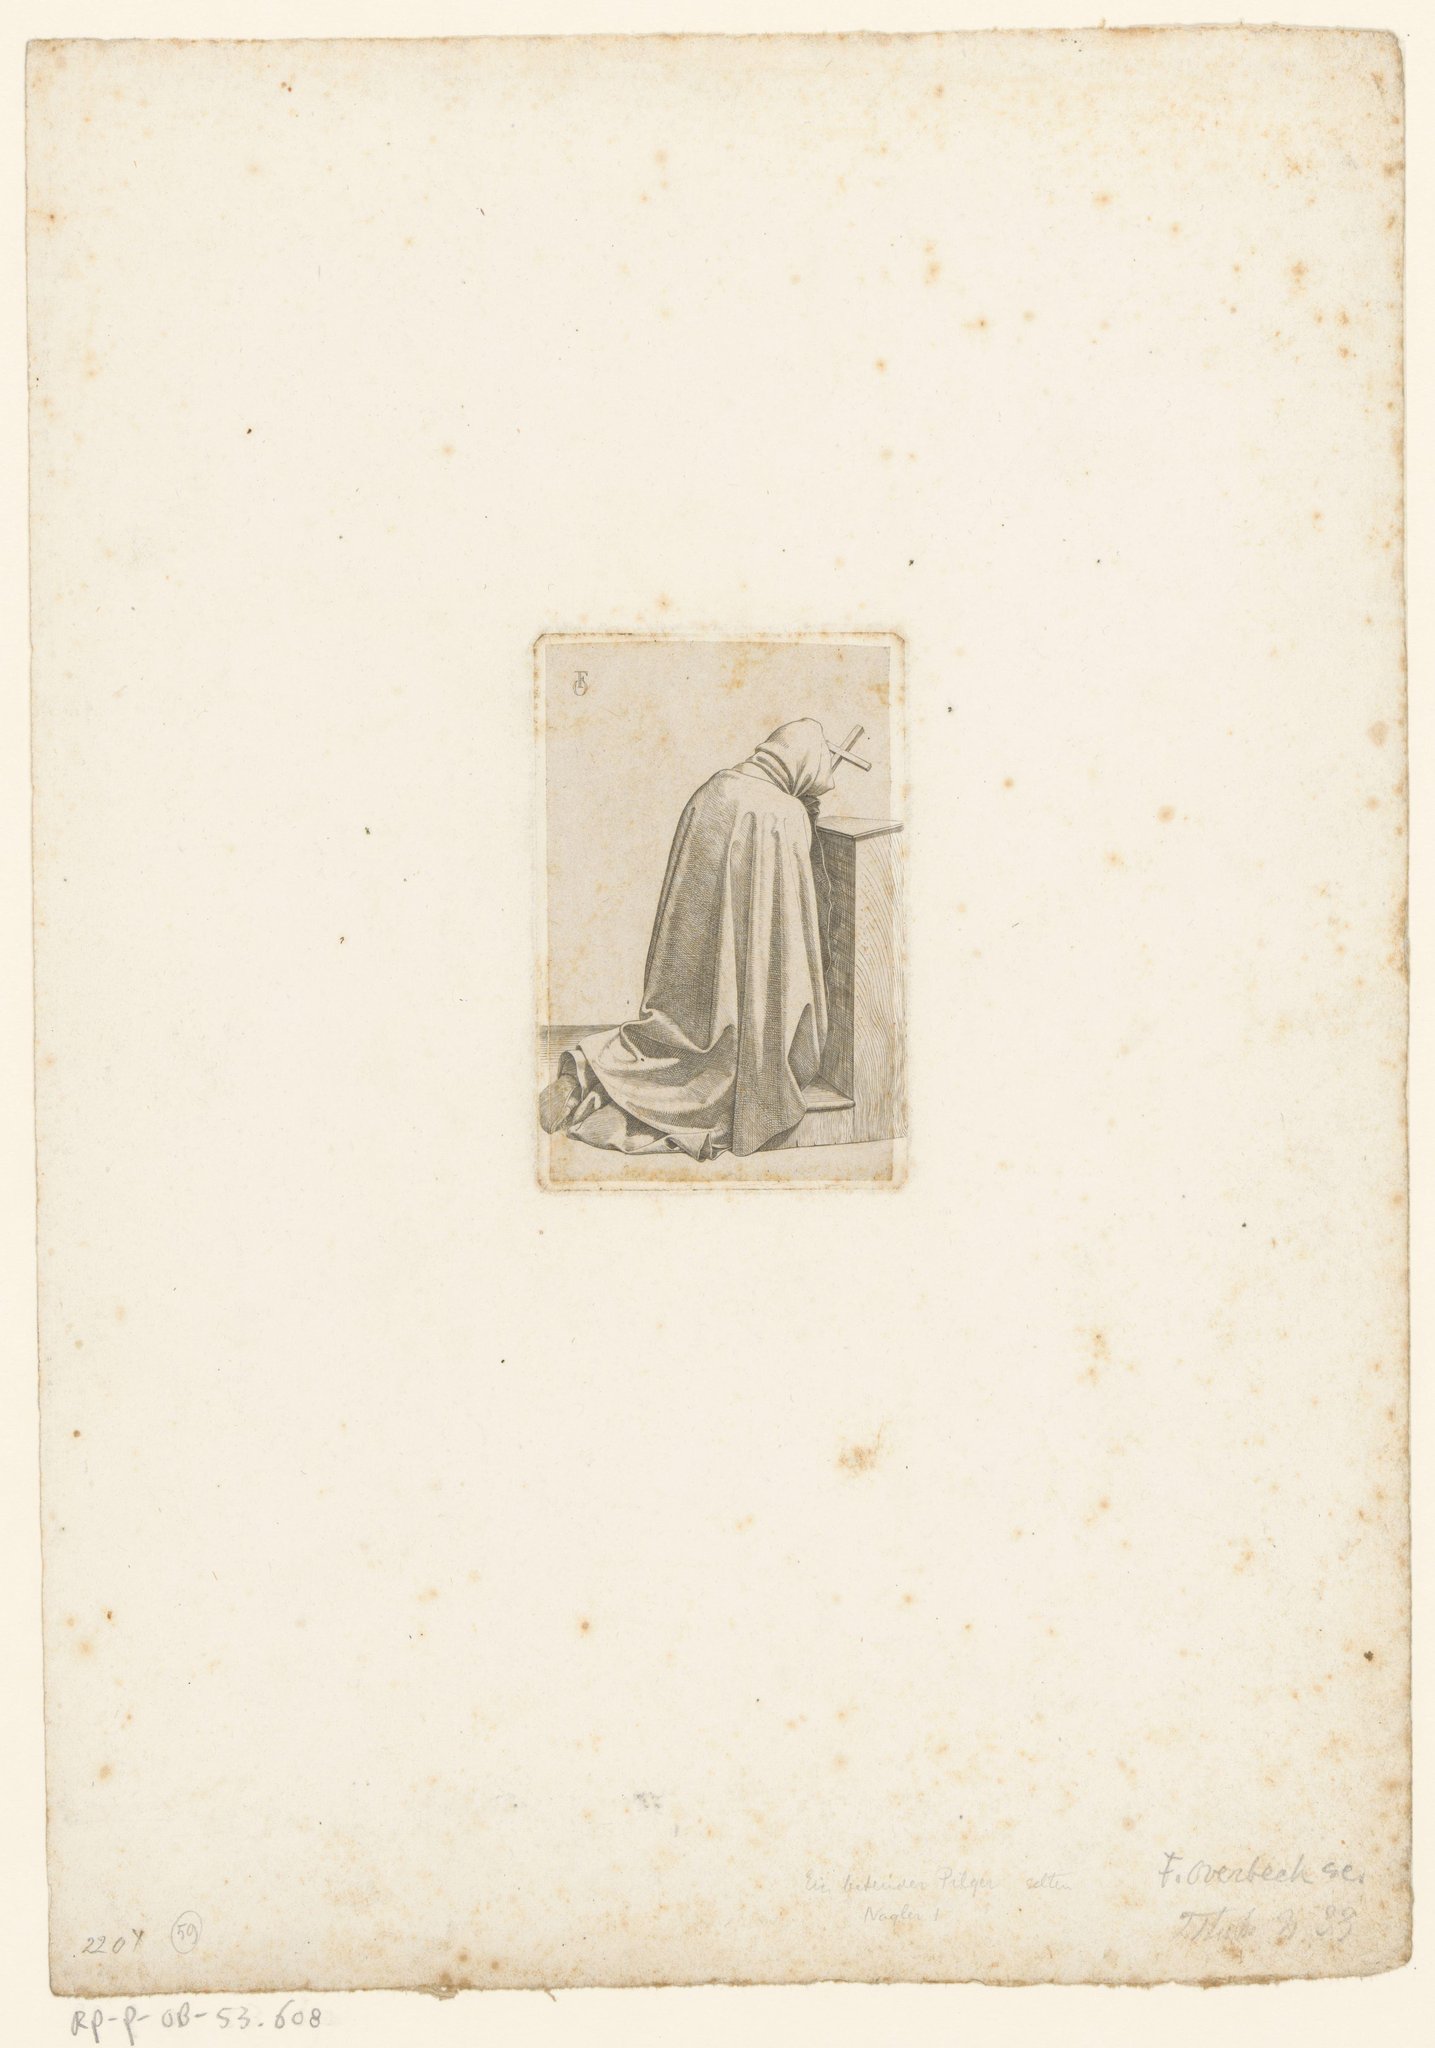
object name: print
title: Biddende monnik op de rug gezien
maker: johann friedrich overbeck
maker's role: painter, print maker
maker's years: 1789-1869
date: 1799-1869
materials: paper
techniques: etching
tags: monk(s), friar(s)